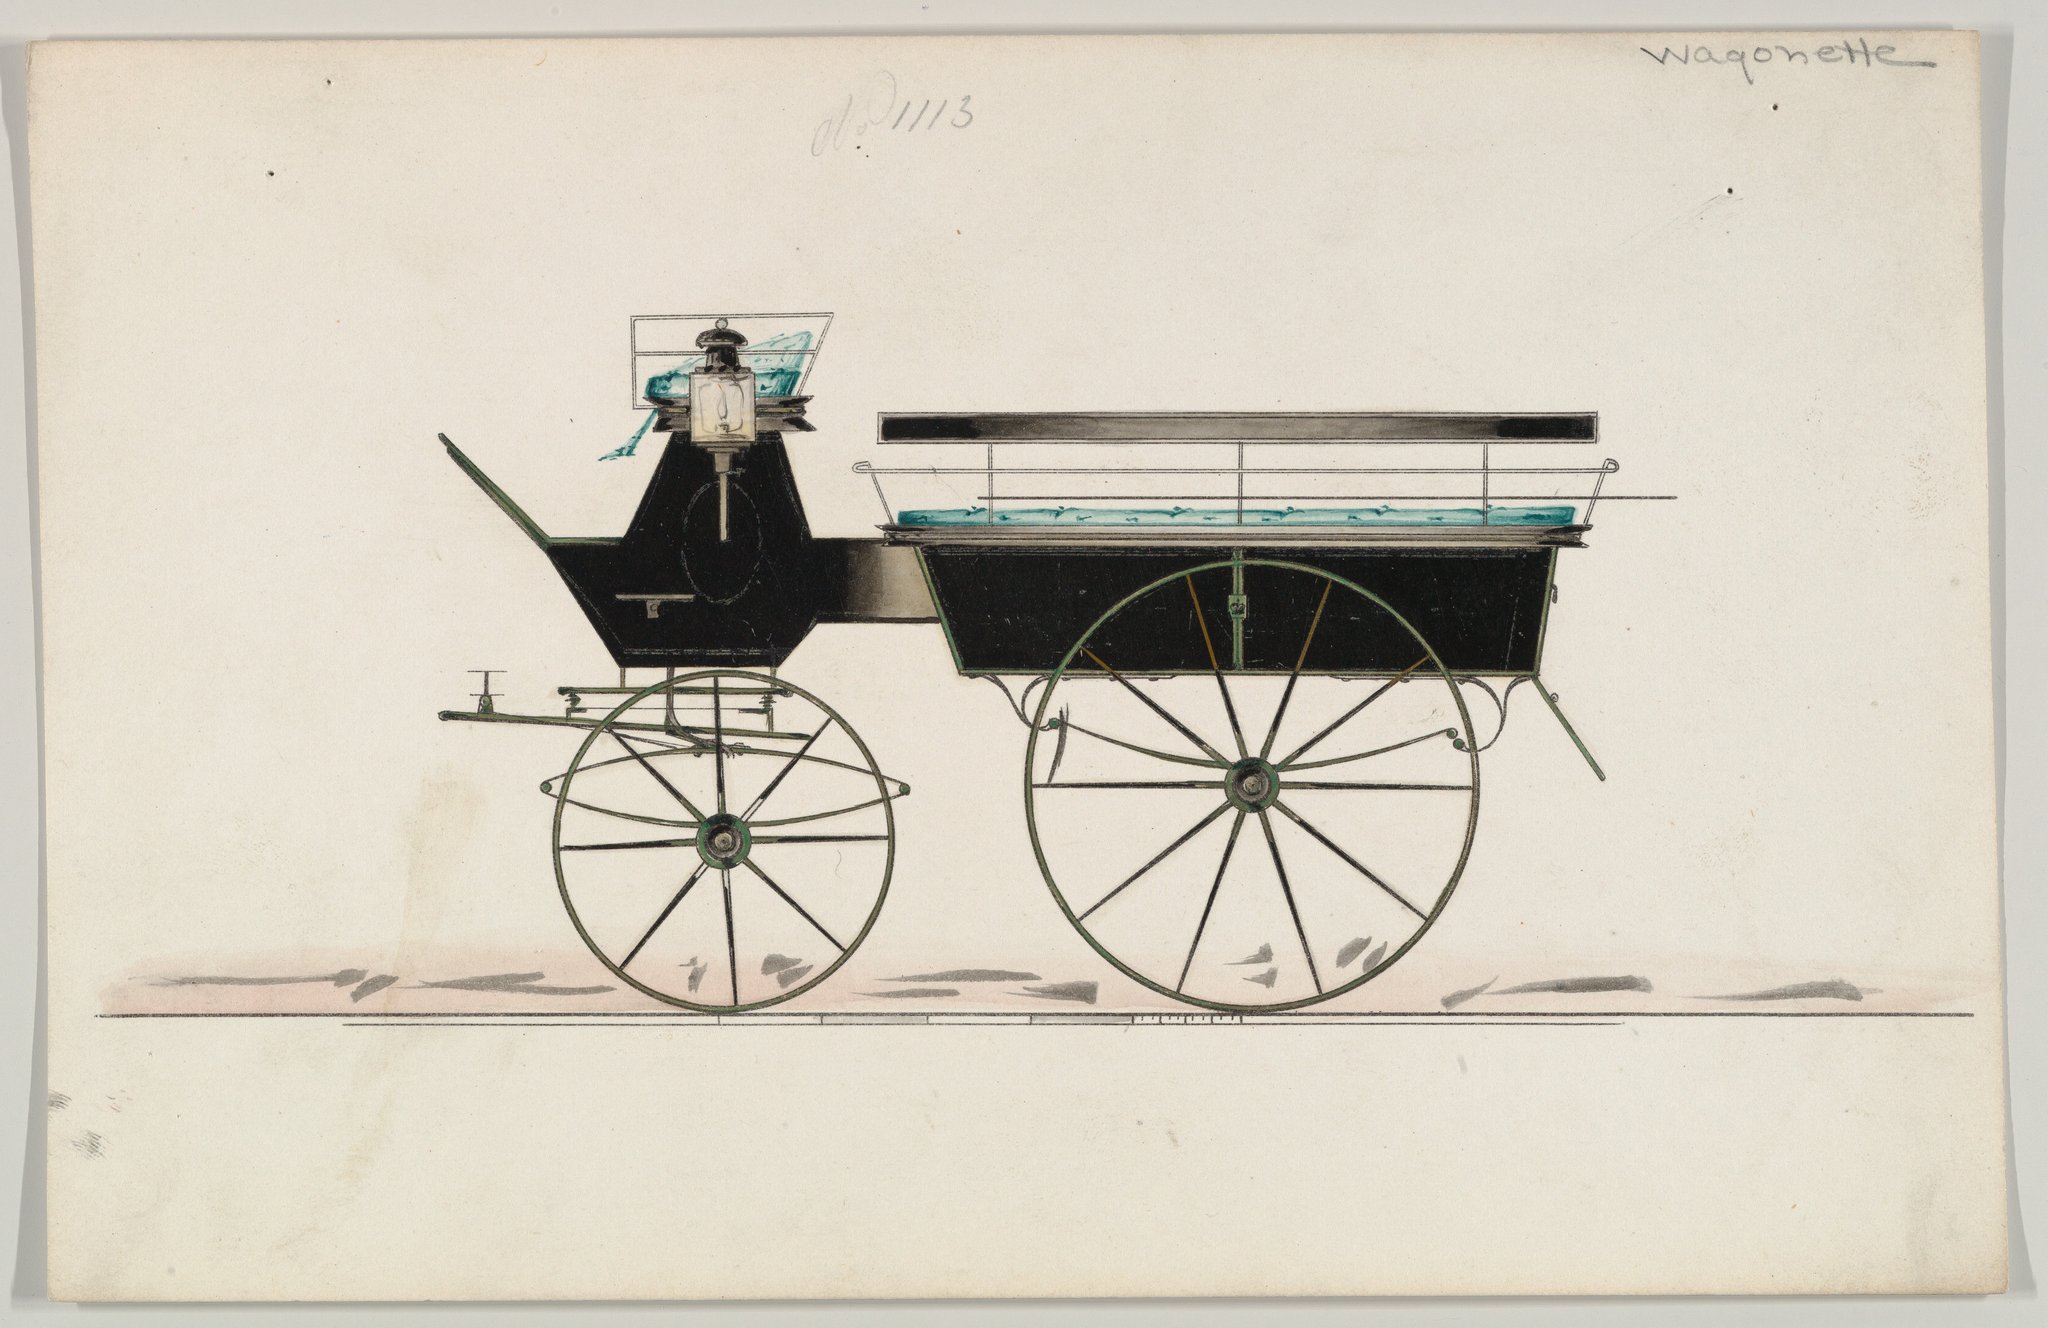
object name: drawing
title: Wagonette #1113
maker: brewster & co.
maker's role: manufacturer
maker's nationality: american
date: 1870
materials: gouache, gum arabic, ink, watercolor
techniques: pen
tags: carriages